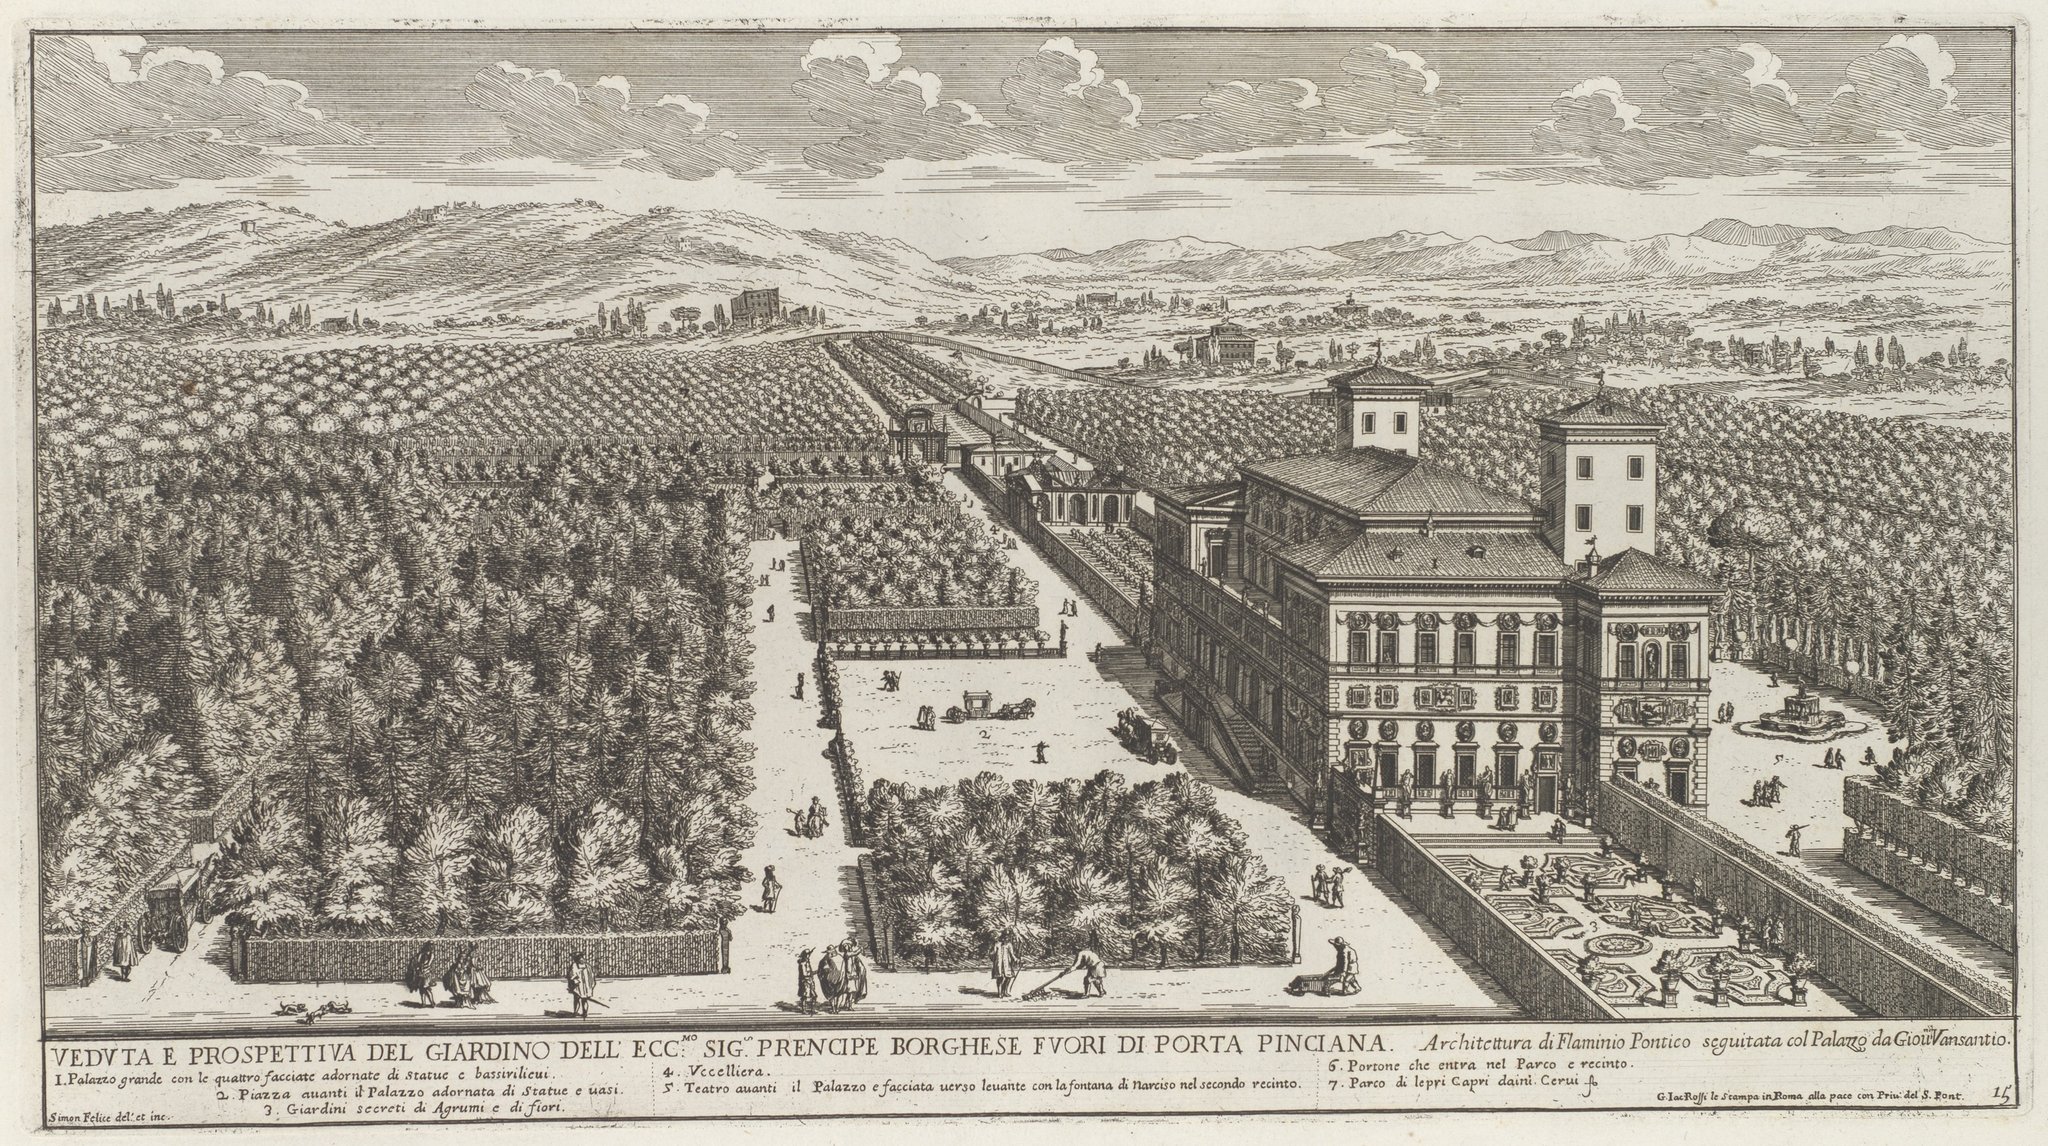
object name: print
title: View of the Villa Borghese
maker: simon felice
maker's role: artist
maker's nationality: italian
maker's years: 1600-1699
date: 1677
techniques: etching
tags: buildings,gardens,landscapes